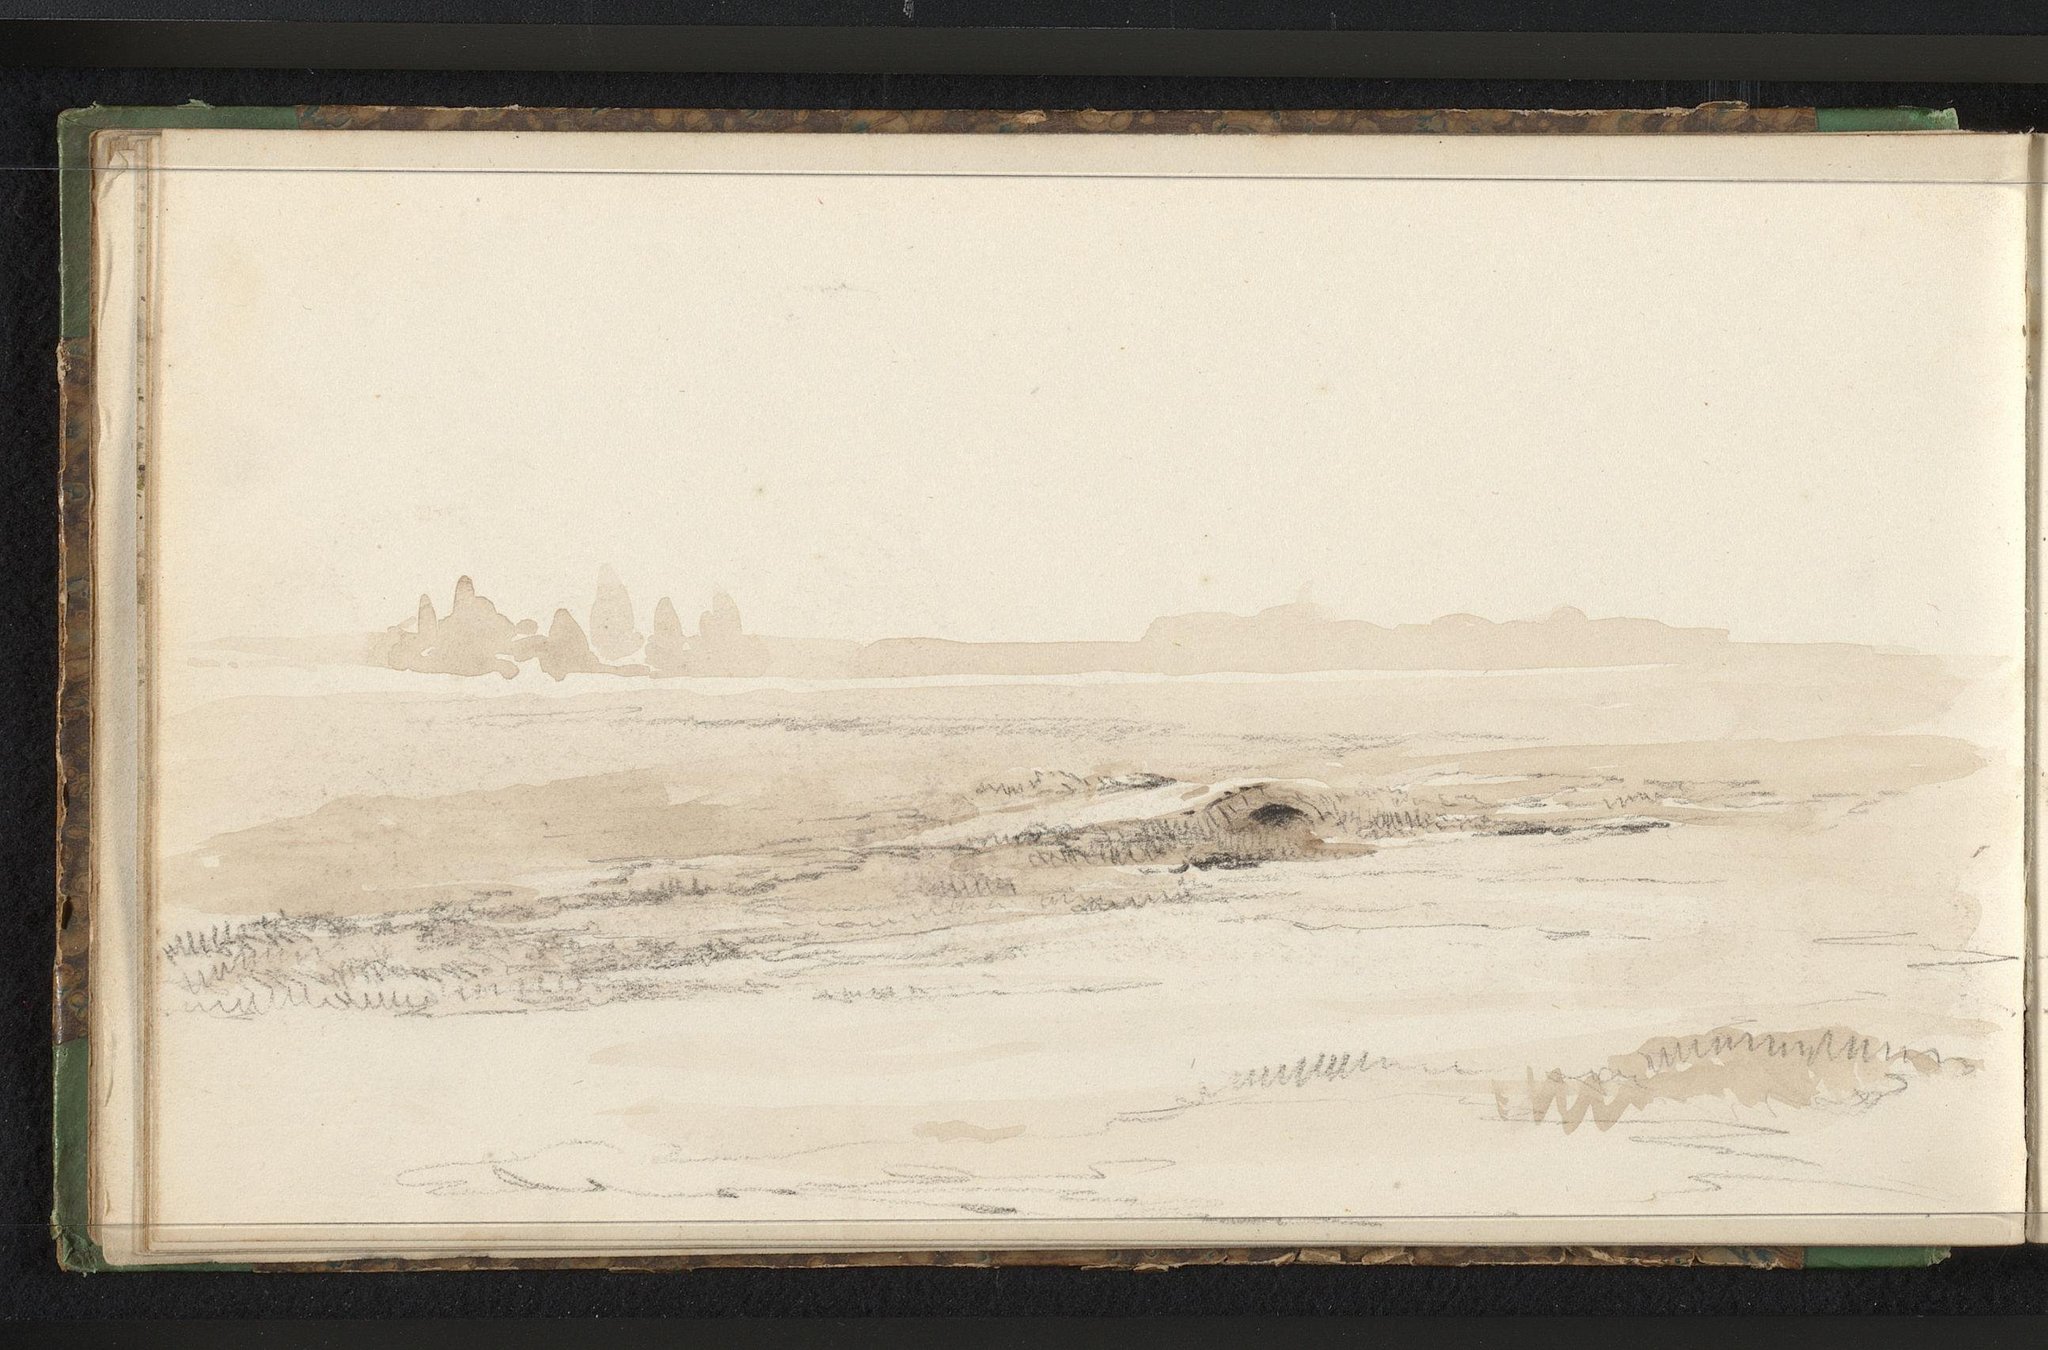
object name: sketchbook leaf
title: Landschap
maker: jan bedijs tom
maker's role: draughtsman, painter, print maker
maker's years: 1813-1894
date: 1828-1894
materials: paper, pencil, watercolor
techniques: brush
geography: the hague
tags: plants; vegetation, landscapes, artist (in general) making preliminary designs, sketching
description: Pagina 25 verso uit een schetsboek met 50 bladen.